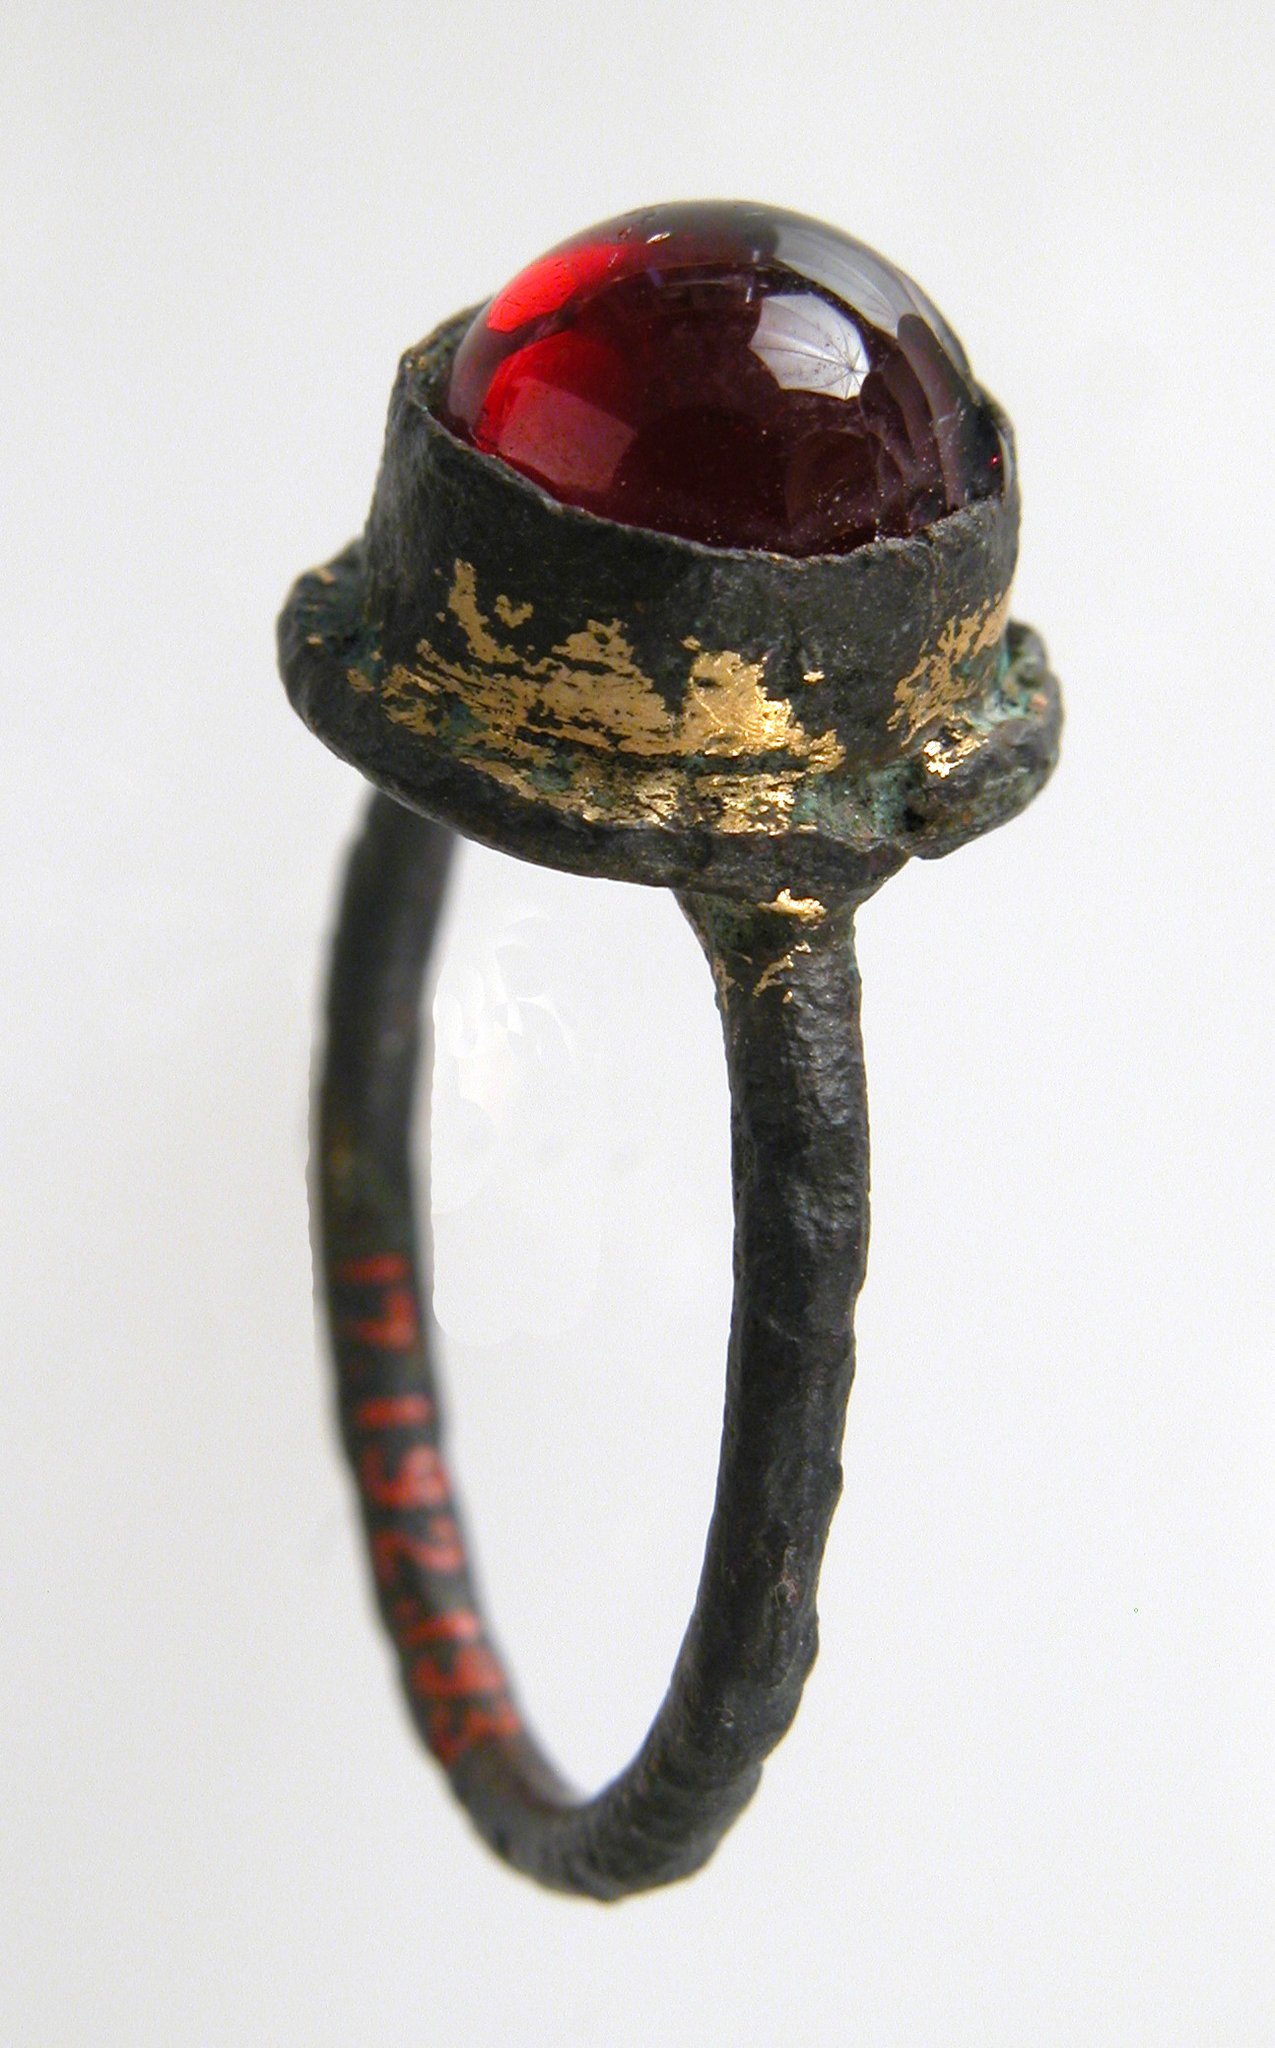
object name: ring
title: Finger Ring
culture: frankish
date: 601-700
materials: copper alloy, gilt, glass, paste, stone